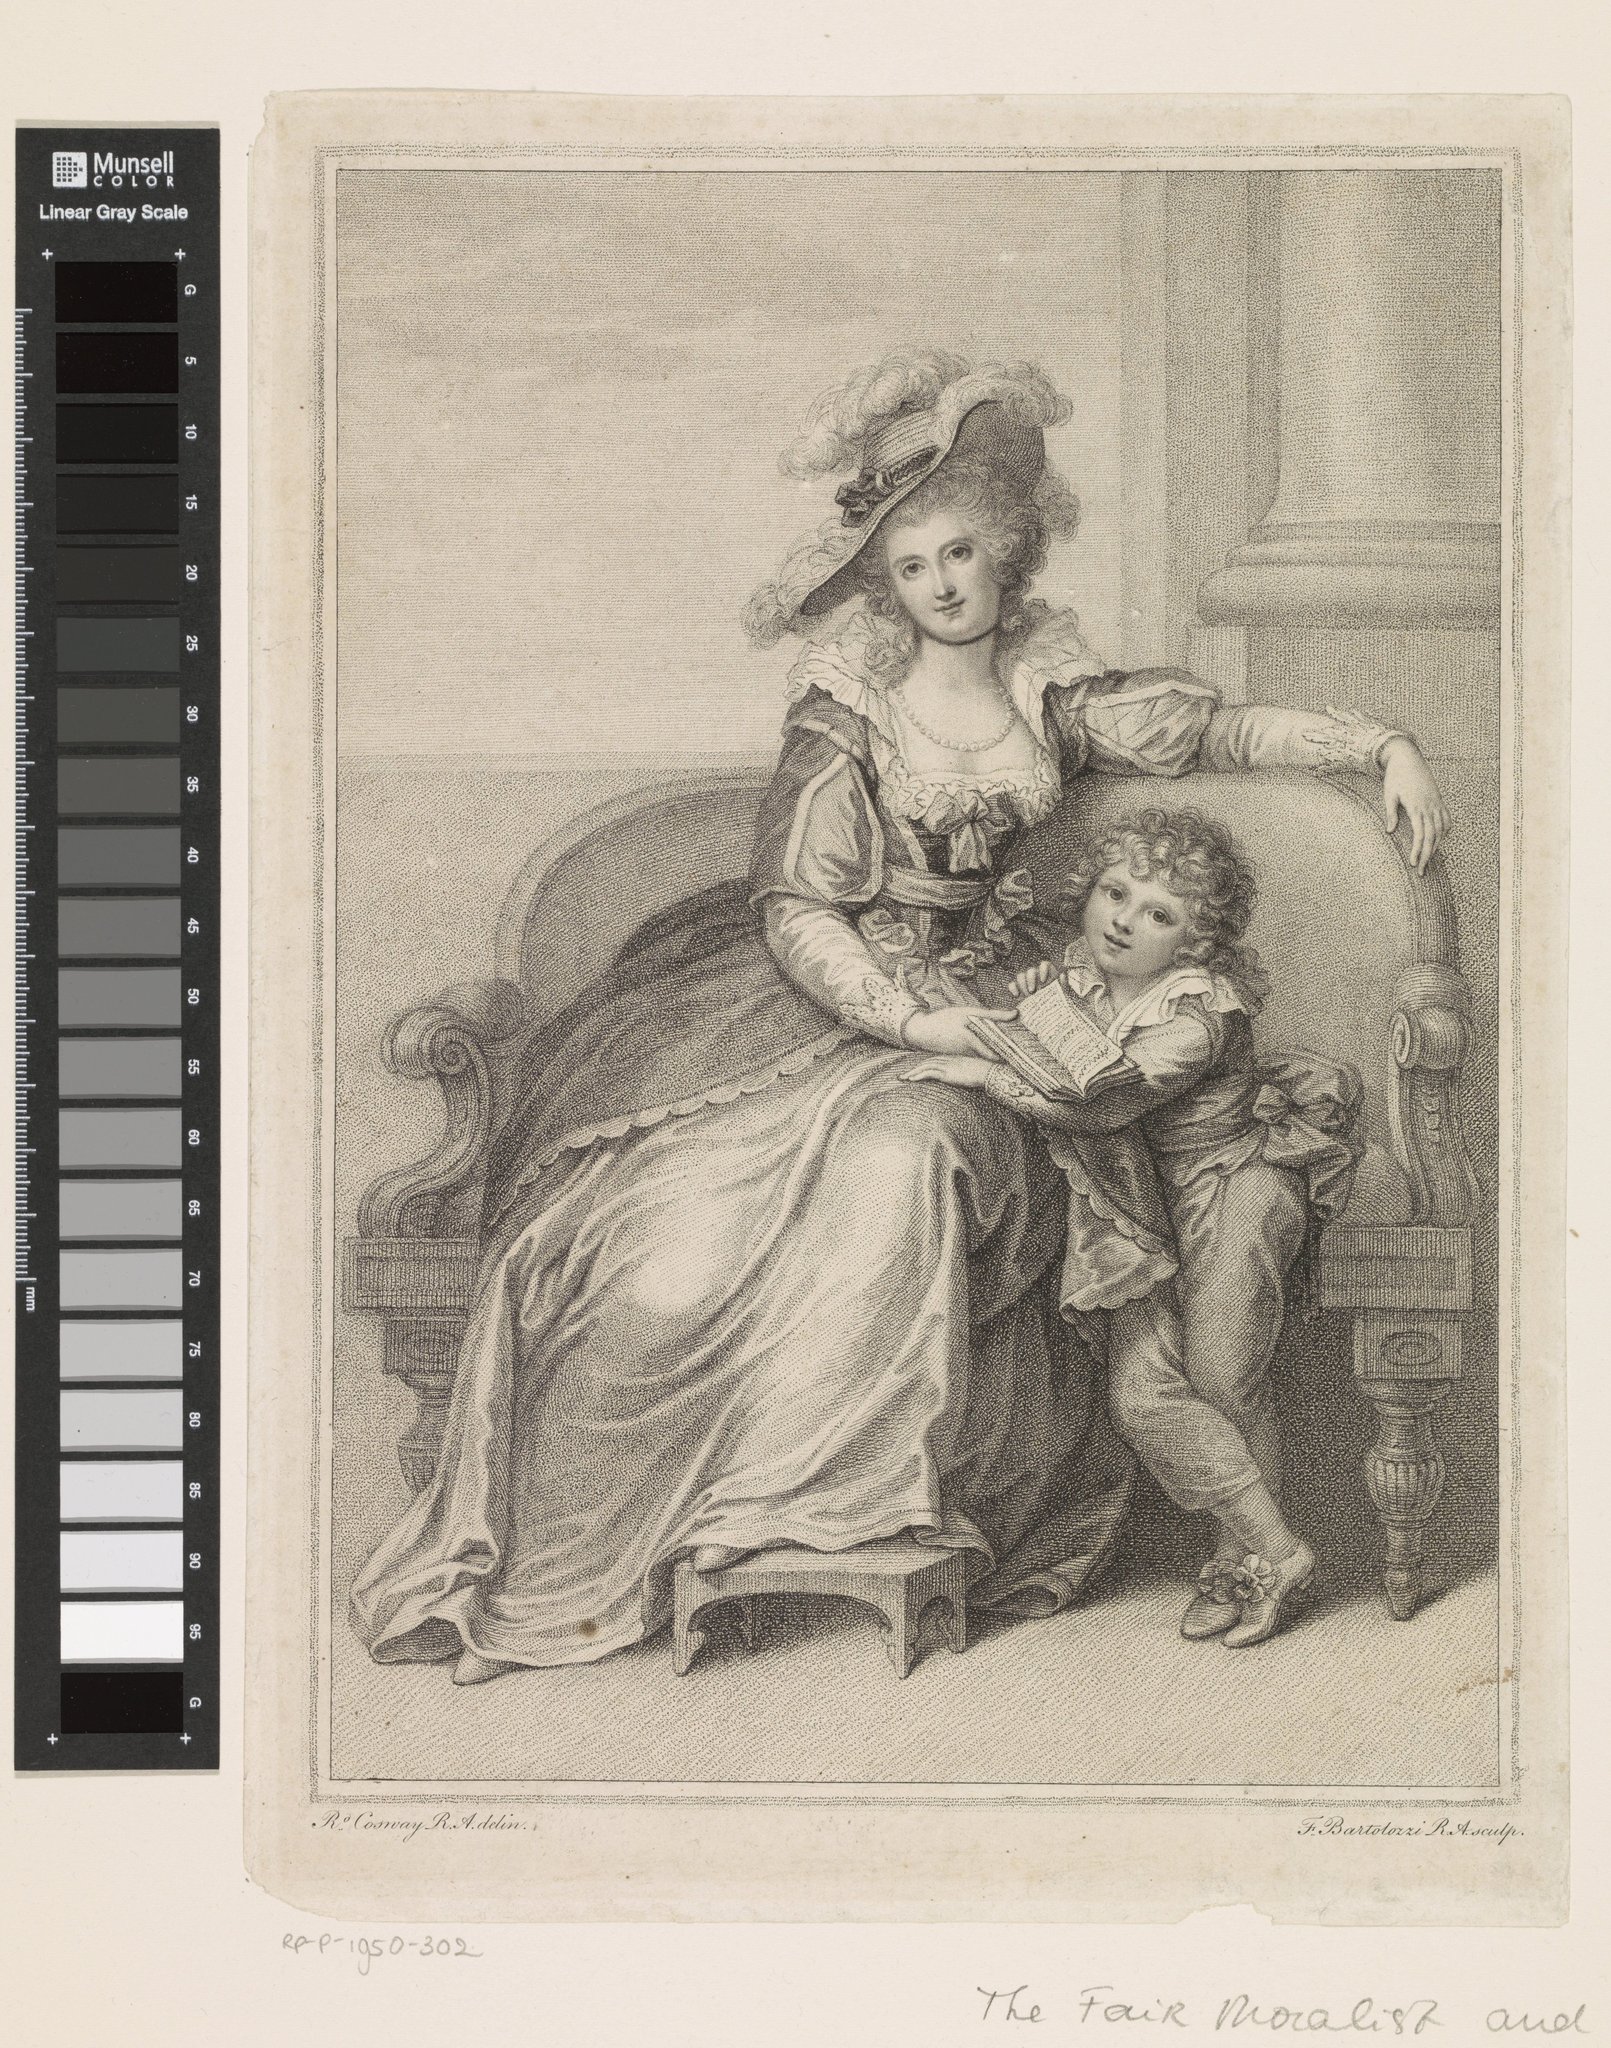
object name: print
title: Mevrouw Hardinge en haar zoon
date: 1738-1815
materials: paper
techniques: etching, engraving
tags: mother and child(ren), woman and child(ren) (family group)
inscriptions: collector's mark: Lugt 2228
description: Mevrouw Hardinge, gezeten op een sofa met een boek in haar rechterhand. Haar zoontje staat naast haar.